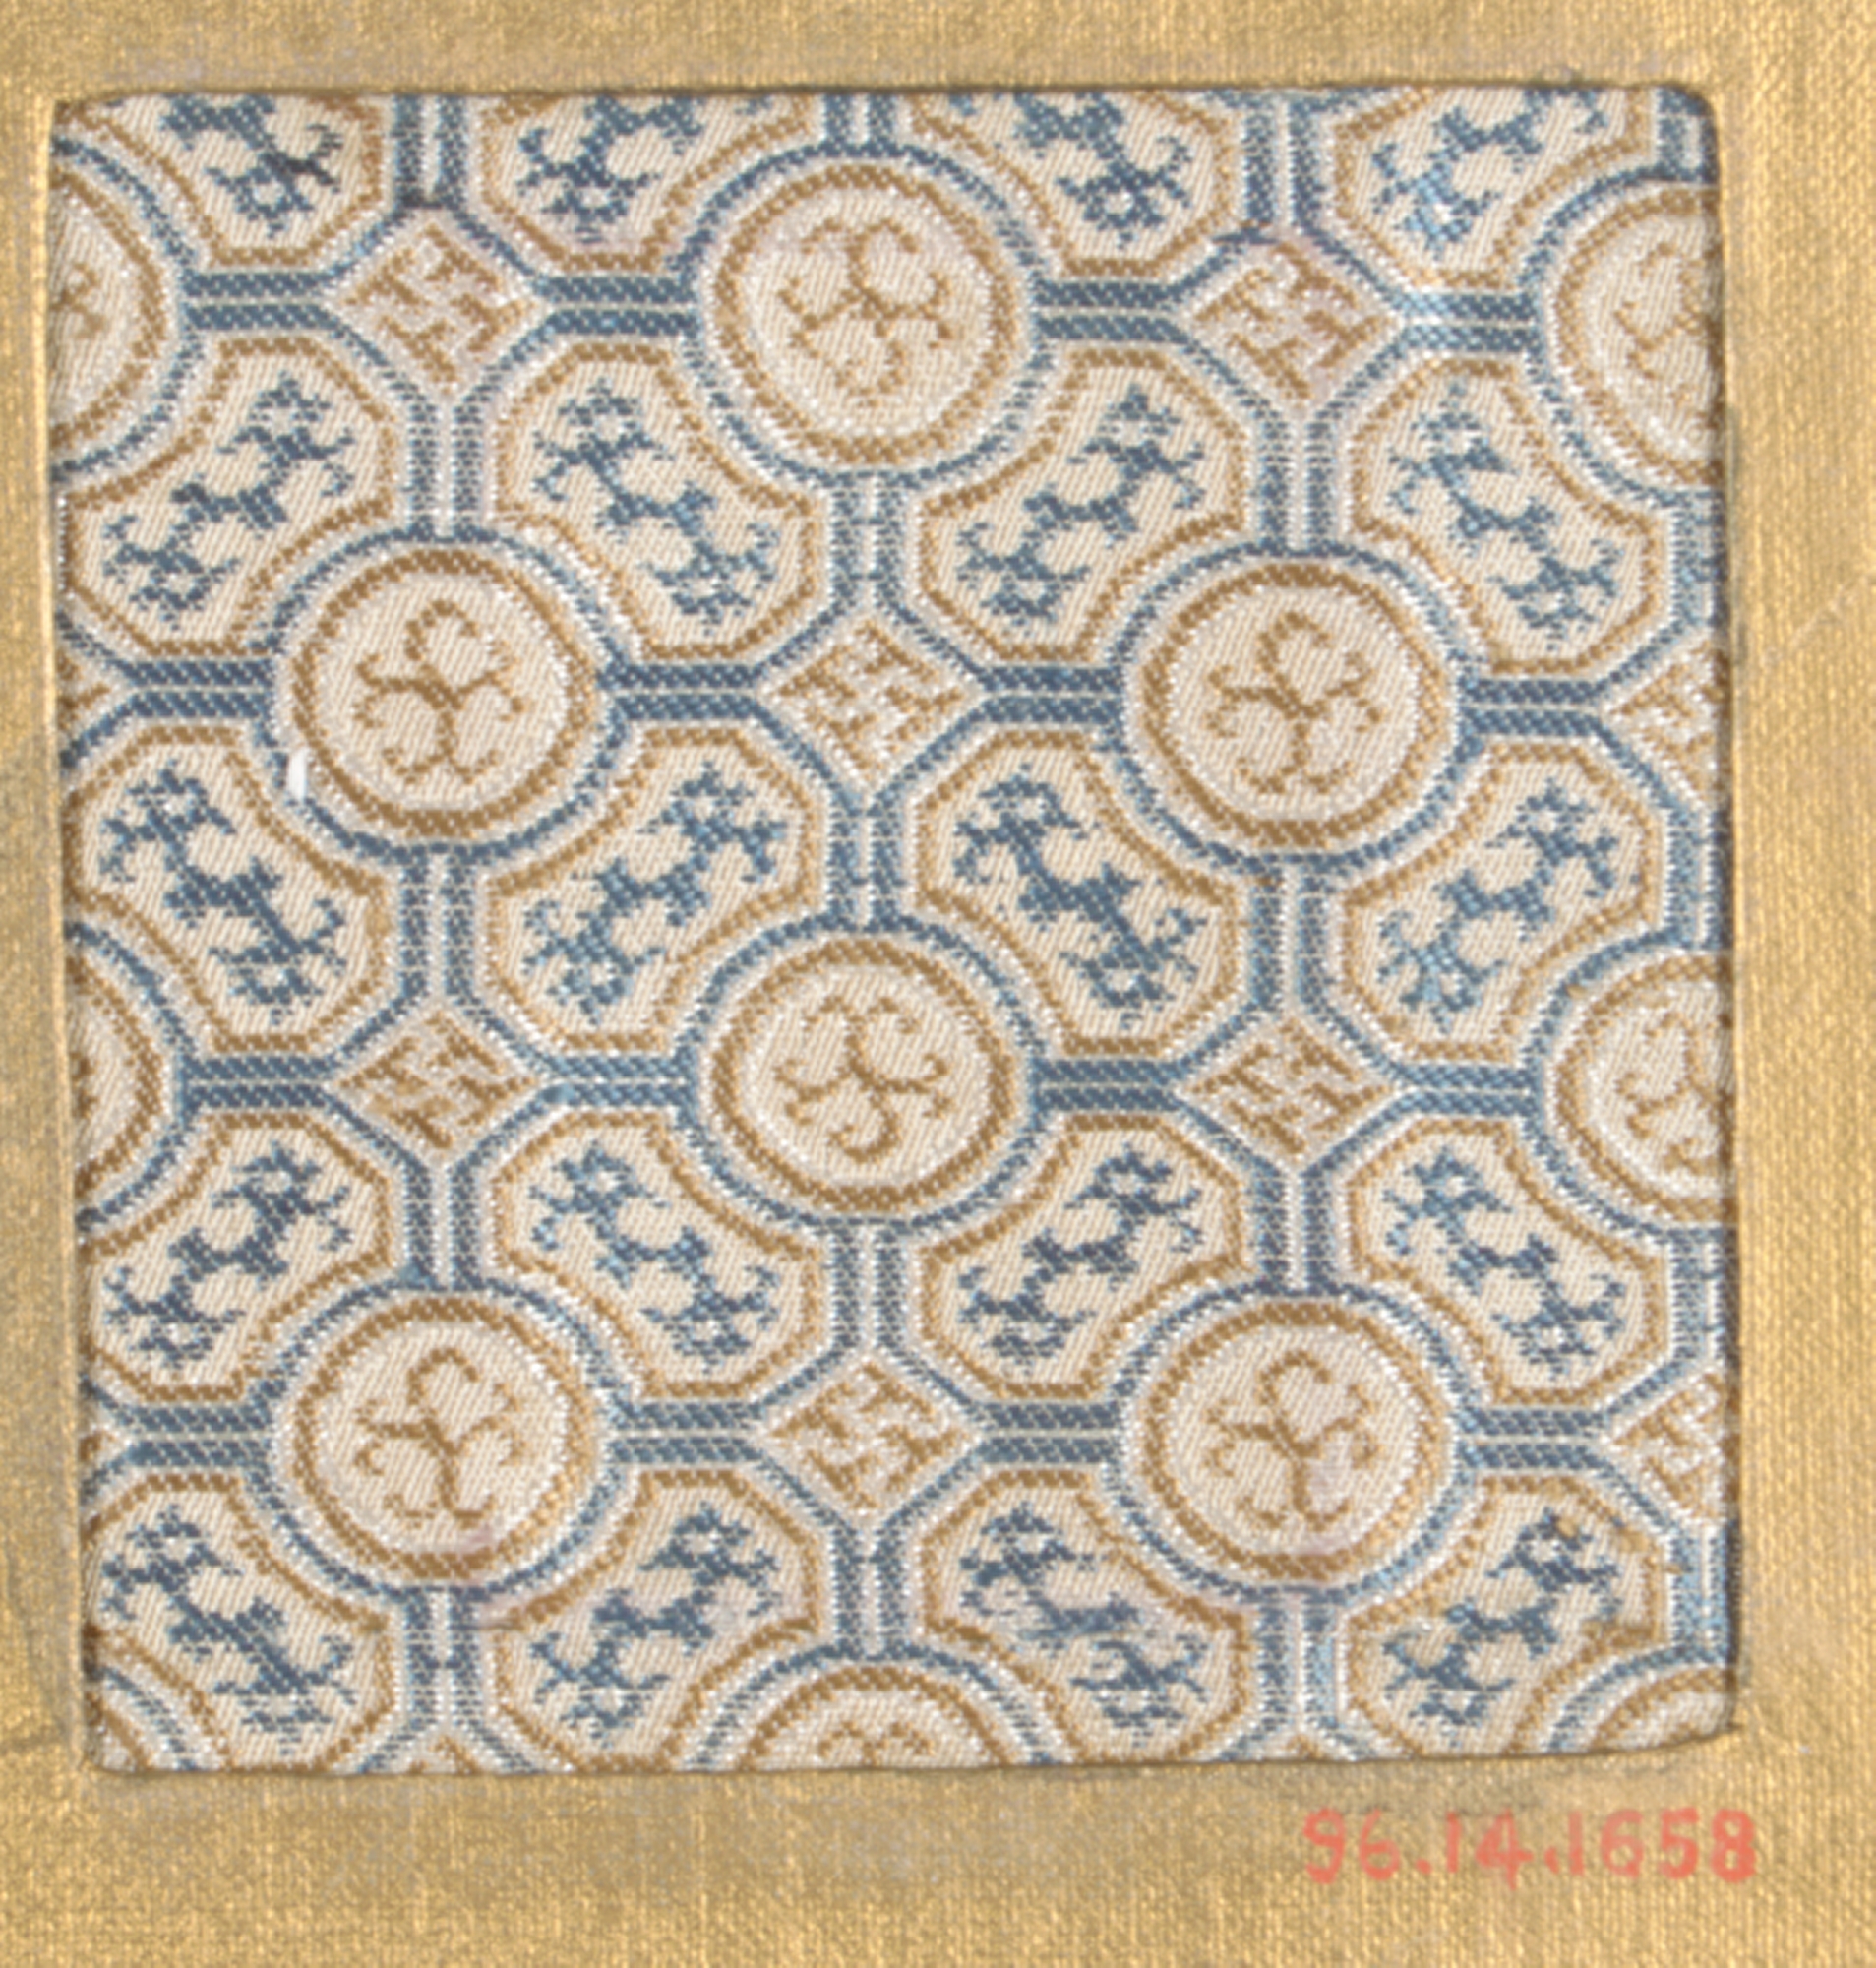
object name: piece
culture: japanese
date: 1701-1900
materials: silk